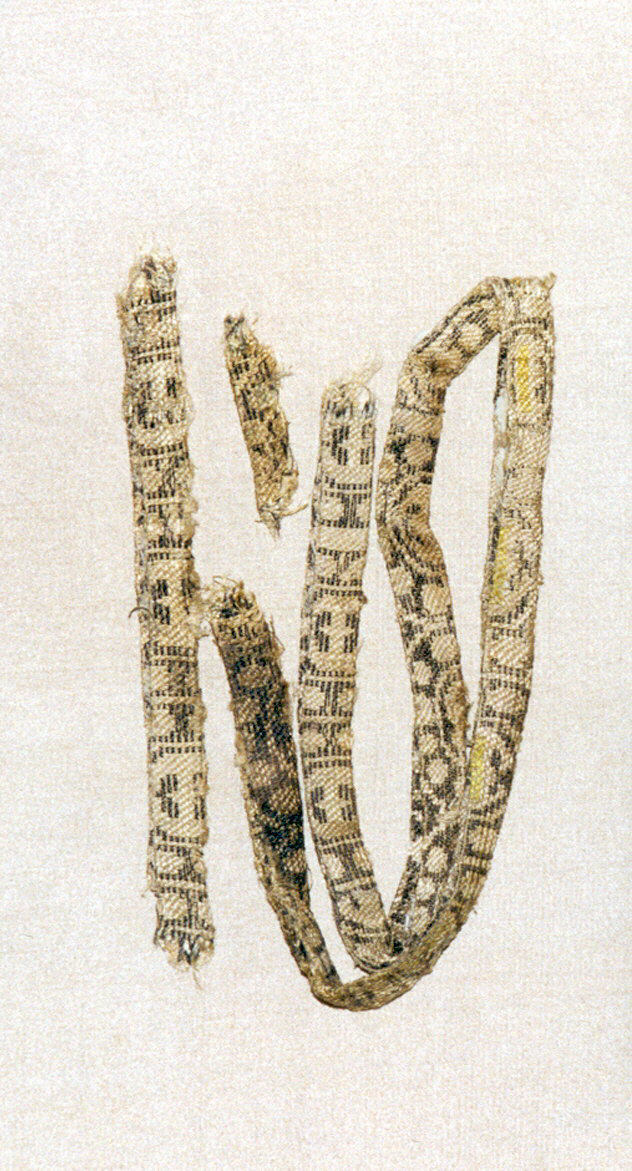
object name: textile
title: Collar trim of a garment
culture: alanic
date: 601-900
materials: silk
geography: caucasus